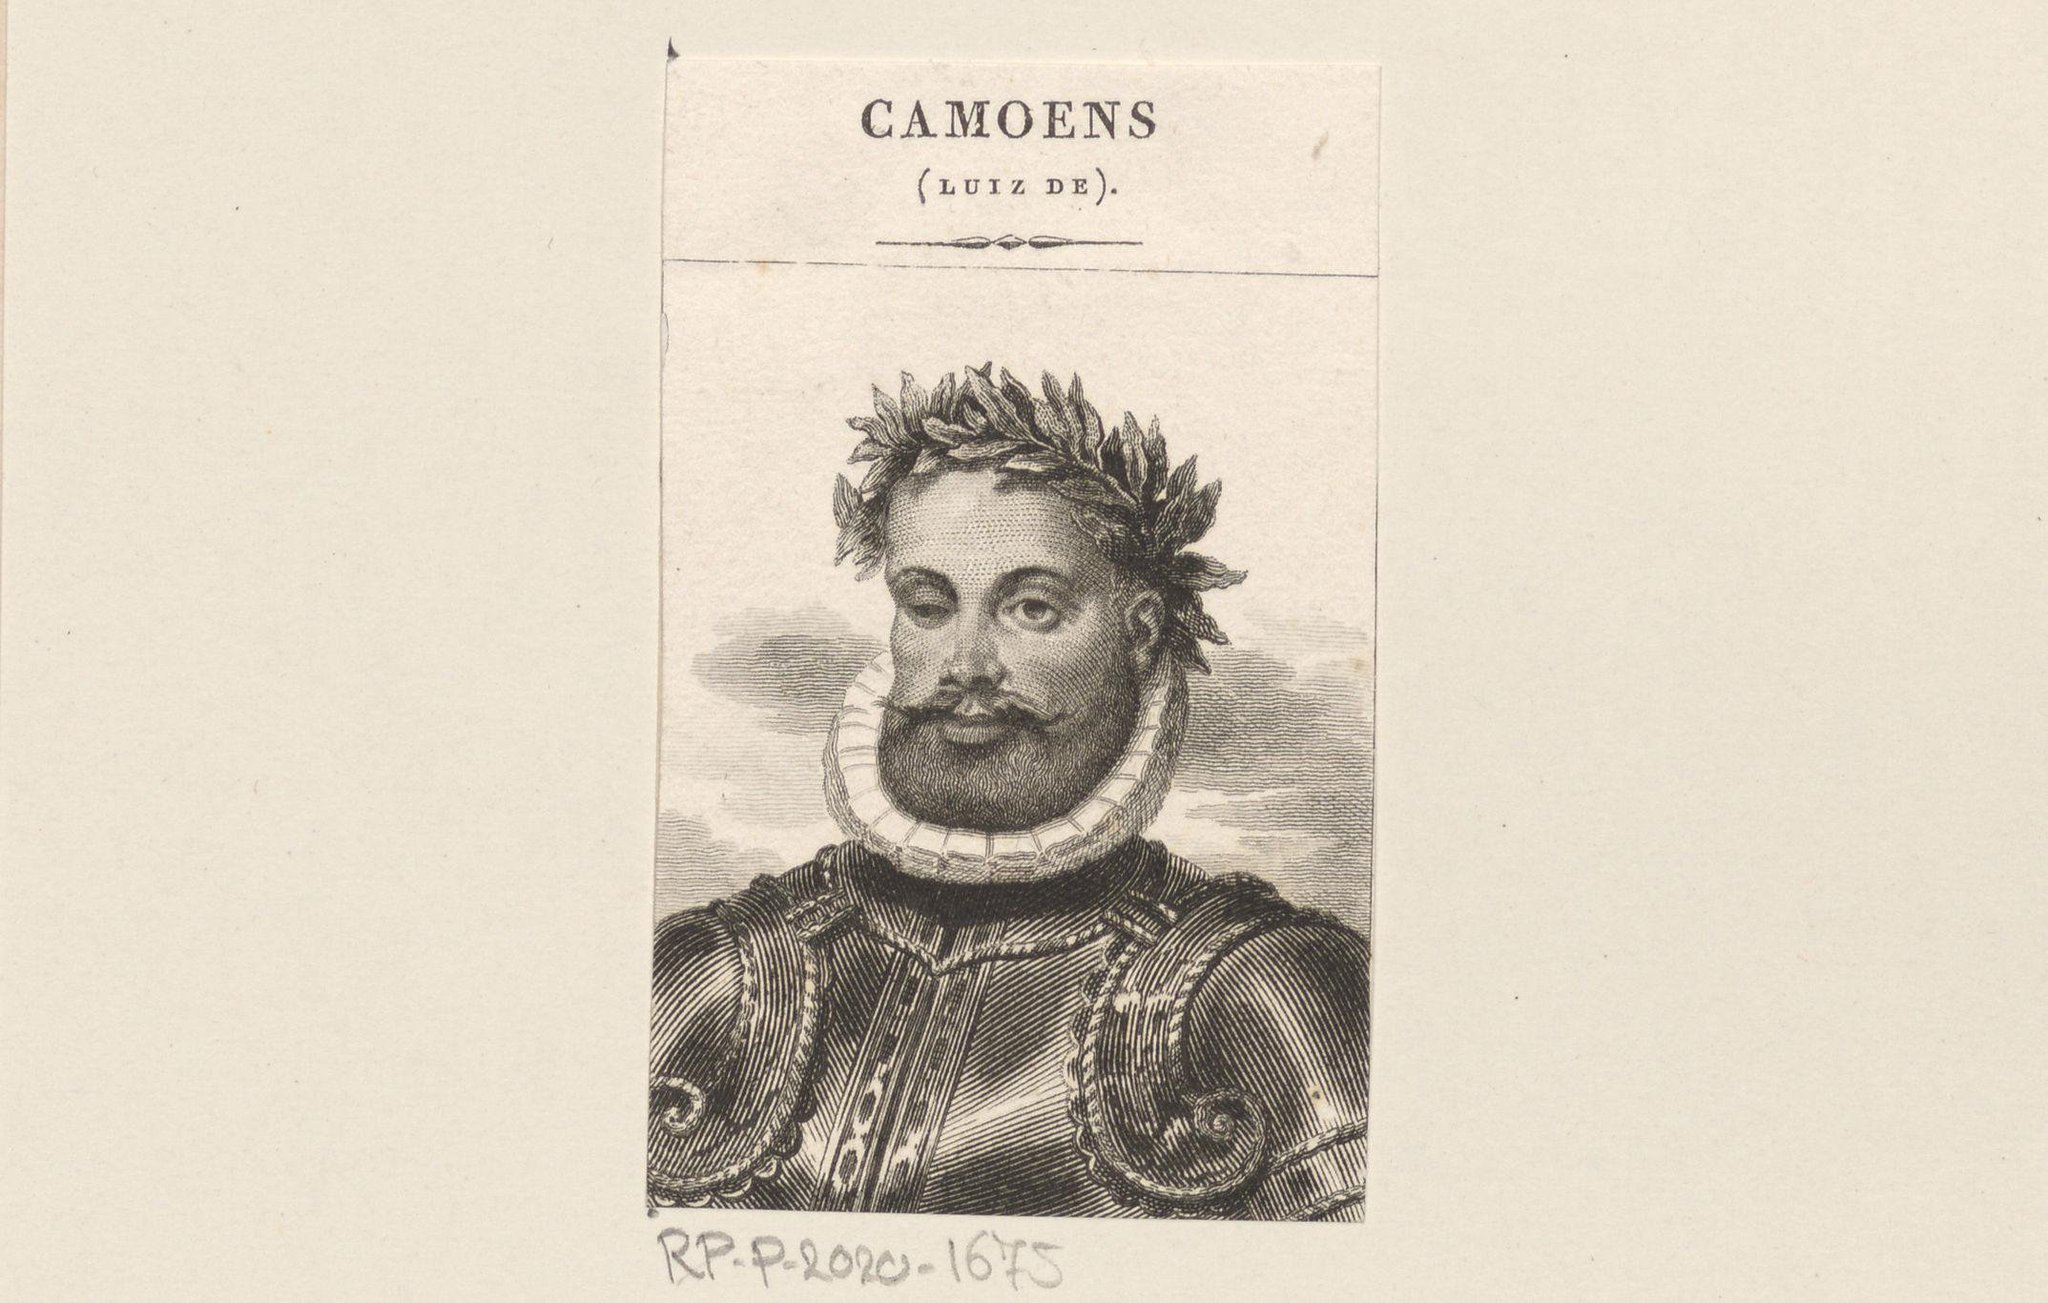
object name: print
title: Portret van Luis de Camões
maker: Anonymous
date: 1750-1849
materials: paper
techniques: engraving, etching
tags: historical persons